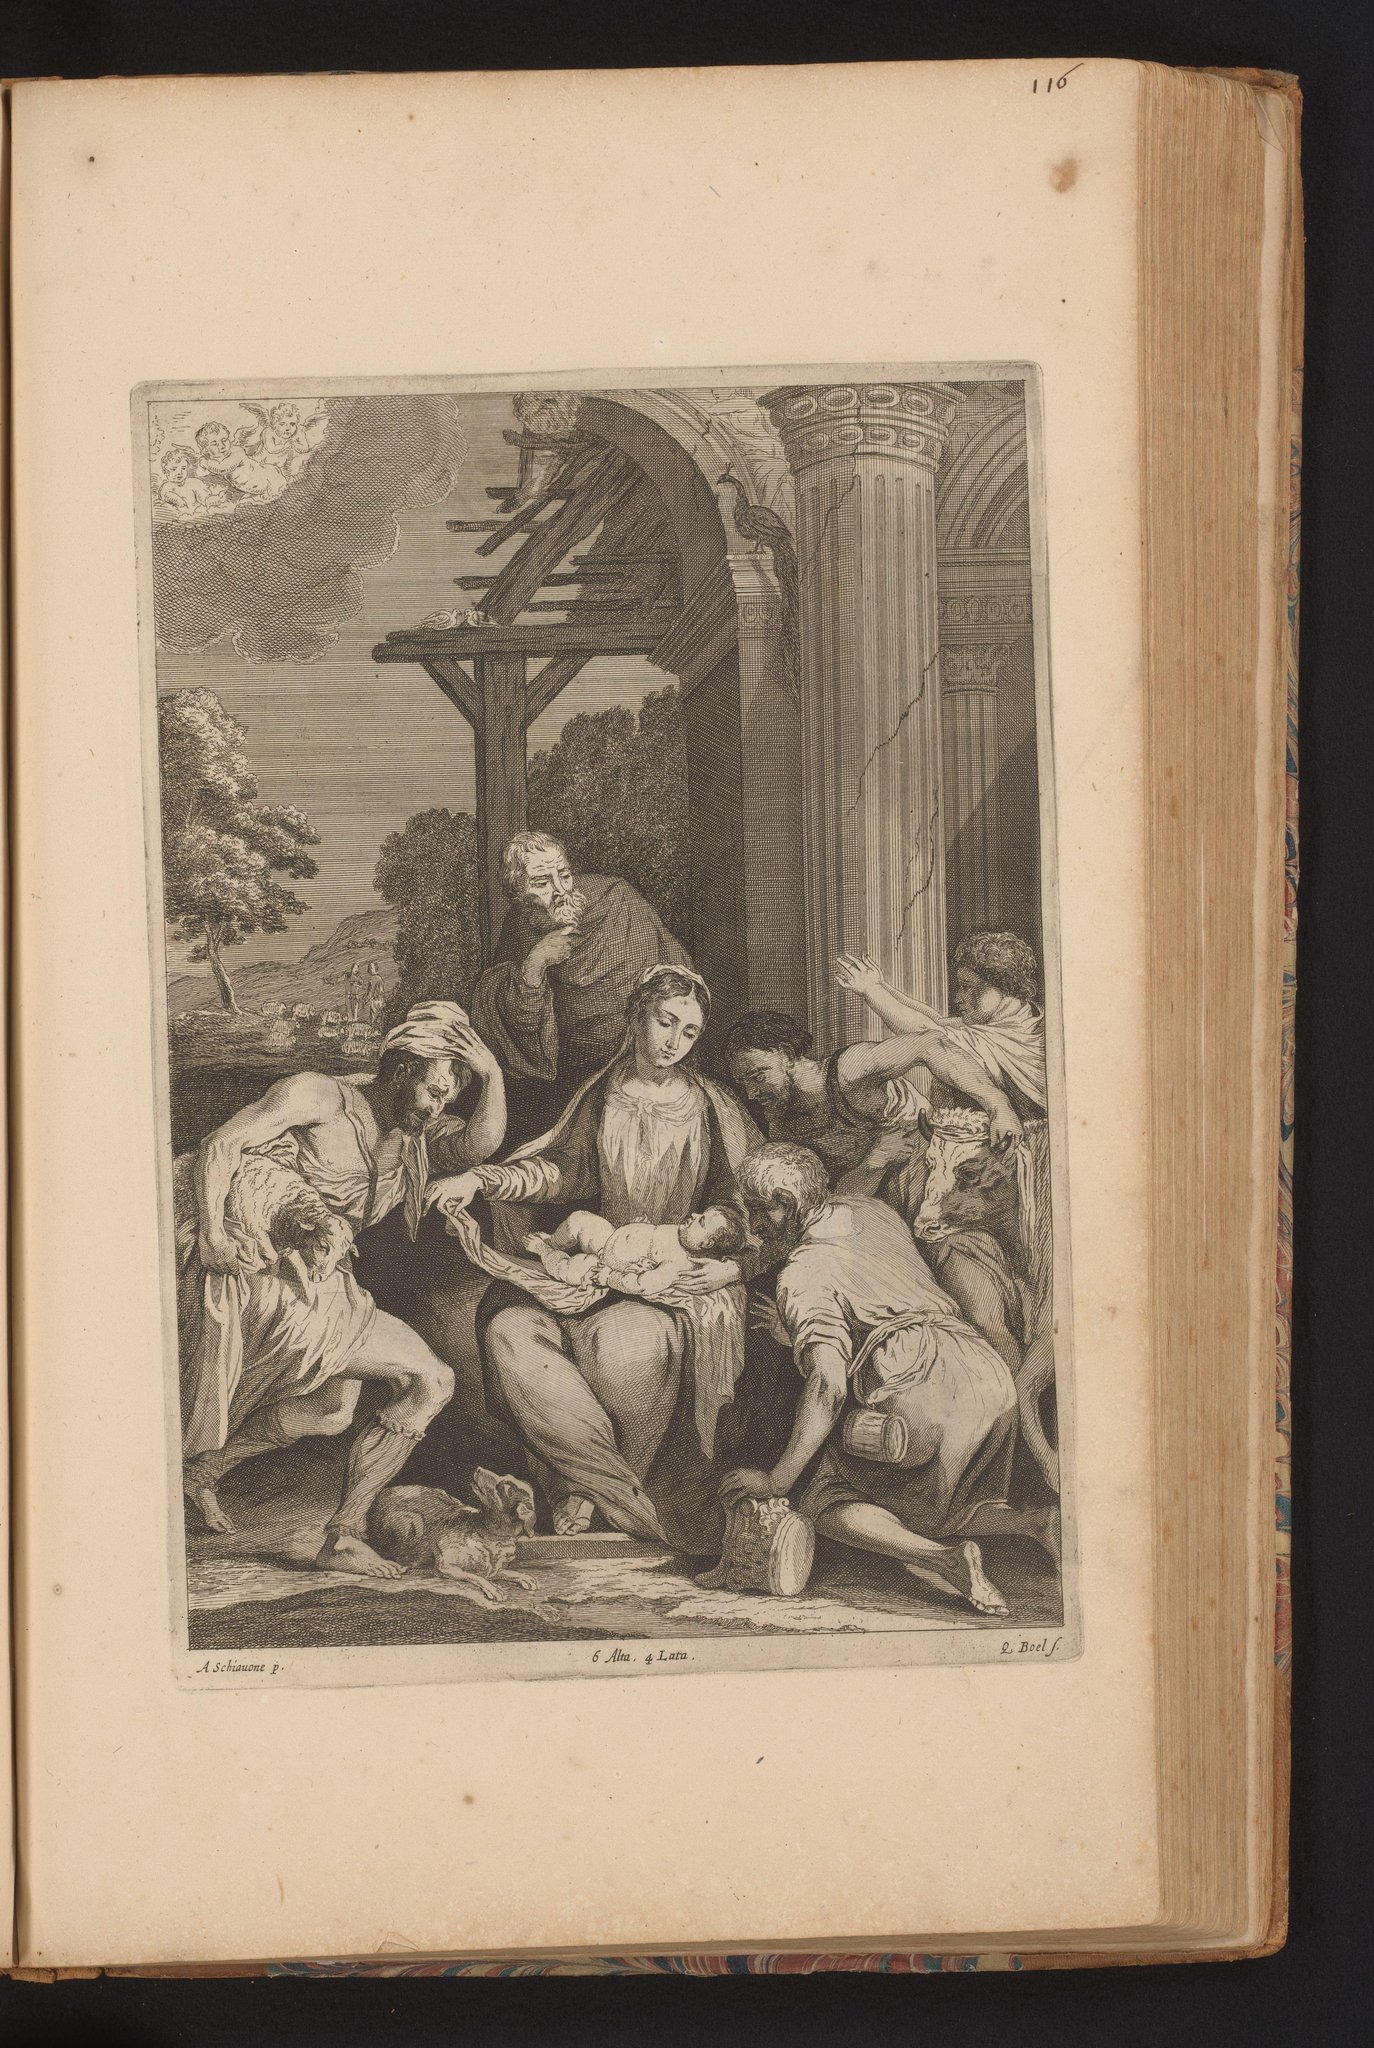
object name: print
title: Aanbidding door de herders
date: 1660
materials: paper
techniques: etching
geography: brussels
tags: adoration of the christ-child by the shepherds; mary and joseph present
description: De prent is vervaardigd naar het schilderij van Schiavone dat zich in de collectie van het Kunsthistorisches Museum te Wenen bevindt (inventarisnummer GG_47). David Teniers heeft waarschijnlijk van alle schilderijen uit de collectie van Leopold Willem van Oostenrijk een olieverfstudie op doek of paneel vervaardigd (zgn. pasticcio), die als voorbeeld voor de prentmakers diende. Het is niet altijd duidelijk of de pasticci door hem zijn gemaakt of door zijn atelier. Niet alle pasticci zijn overgeleverd.